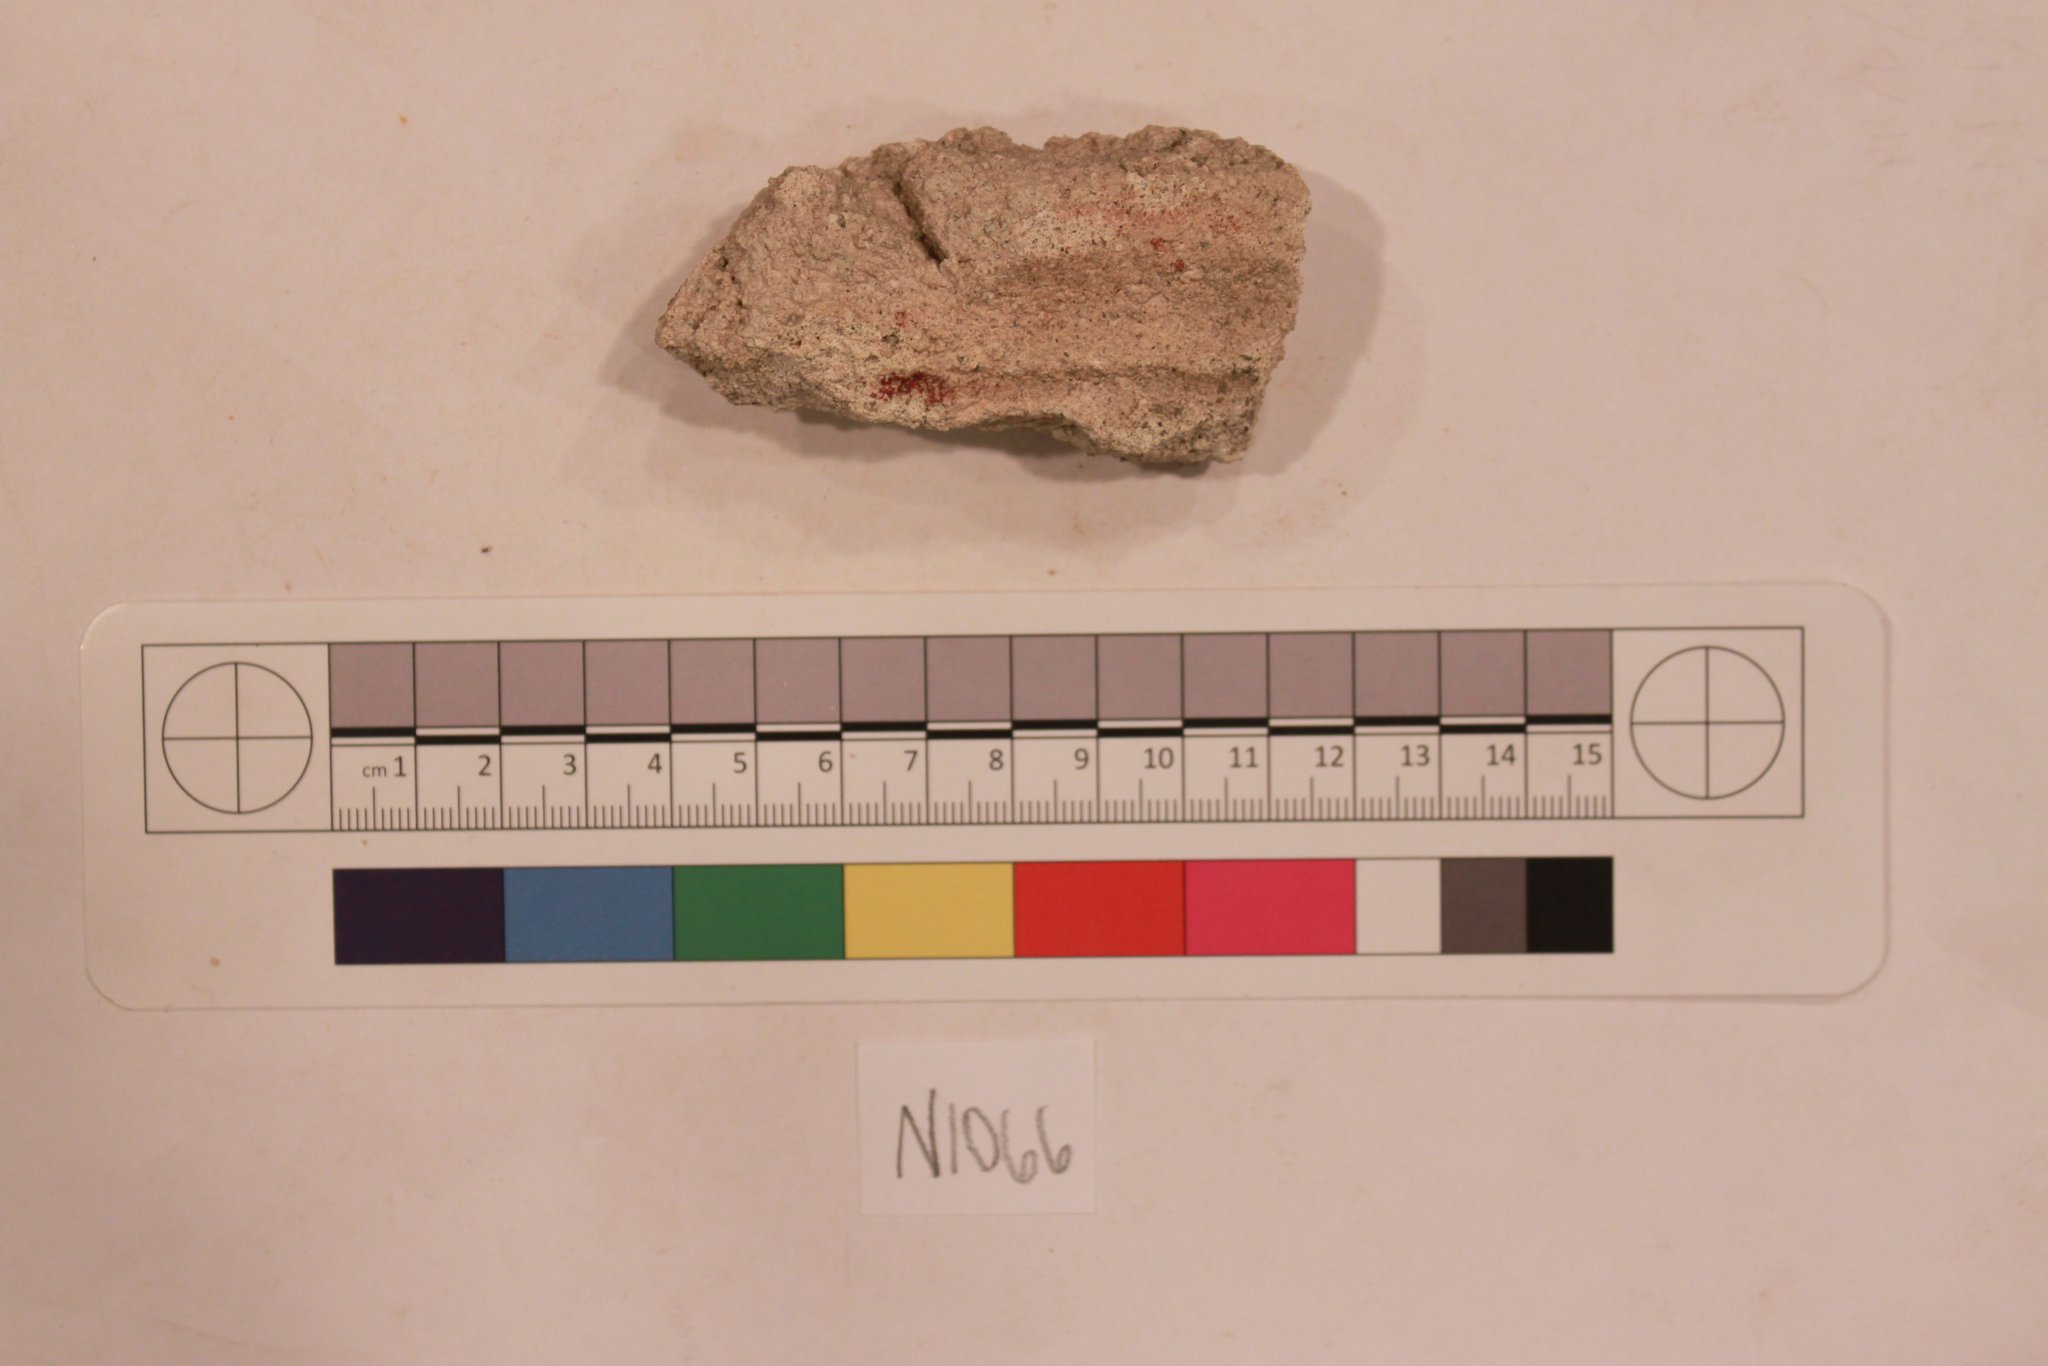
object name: fragment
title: Stucco Fragment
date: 701-1200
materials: plaster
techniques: carving, painting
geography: iran